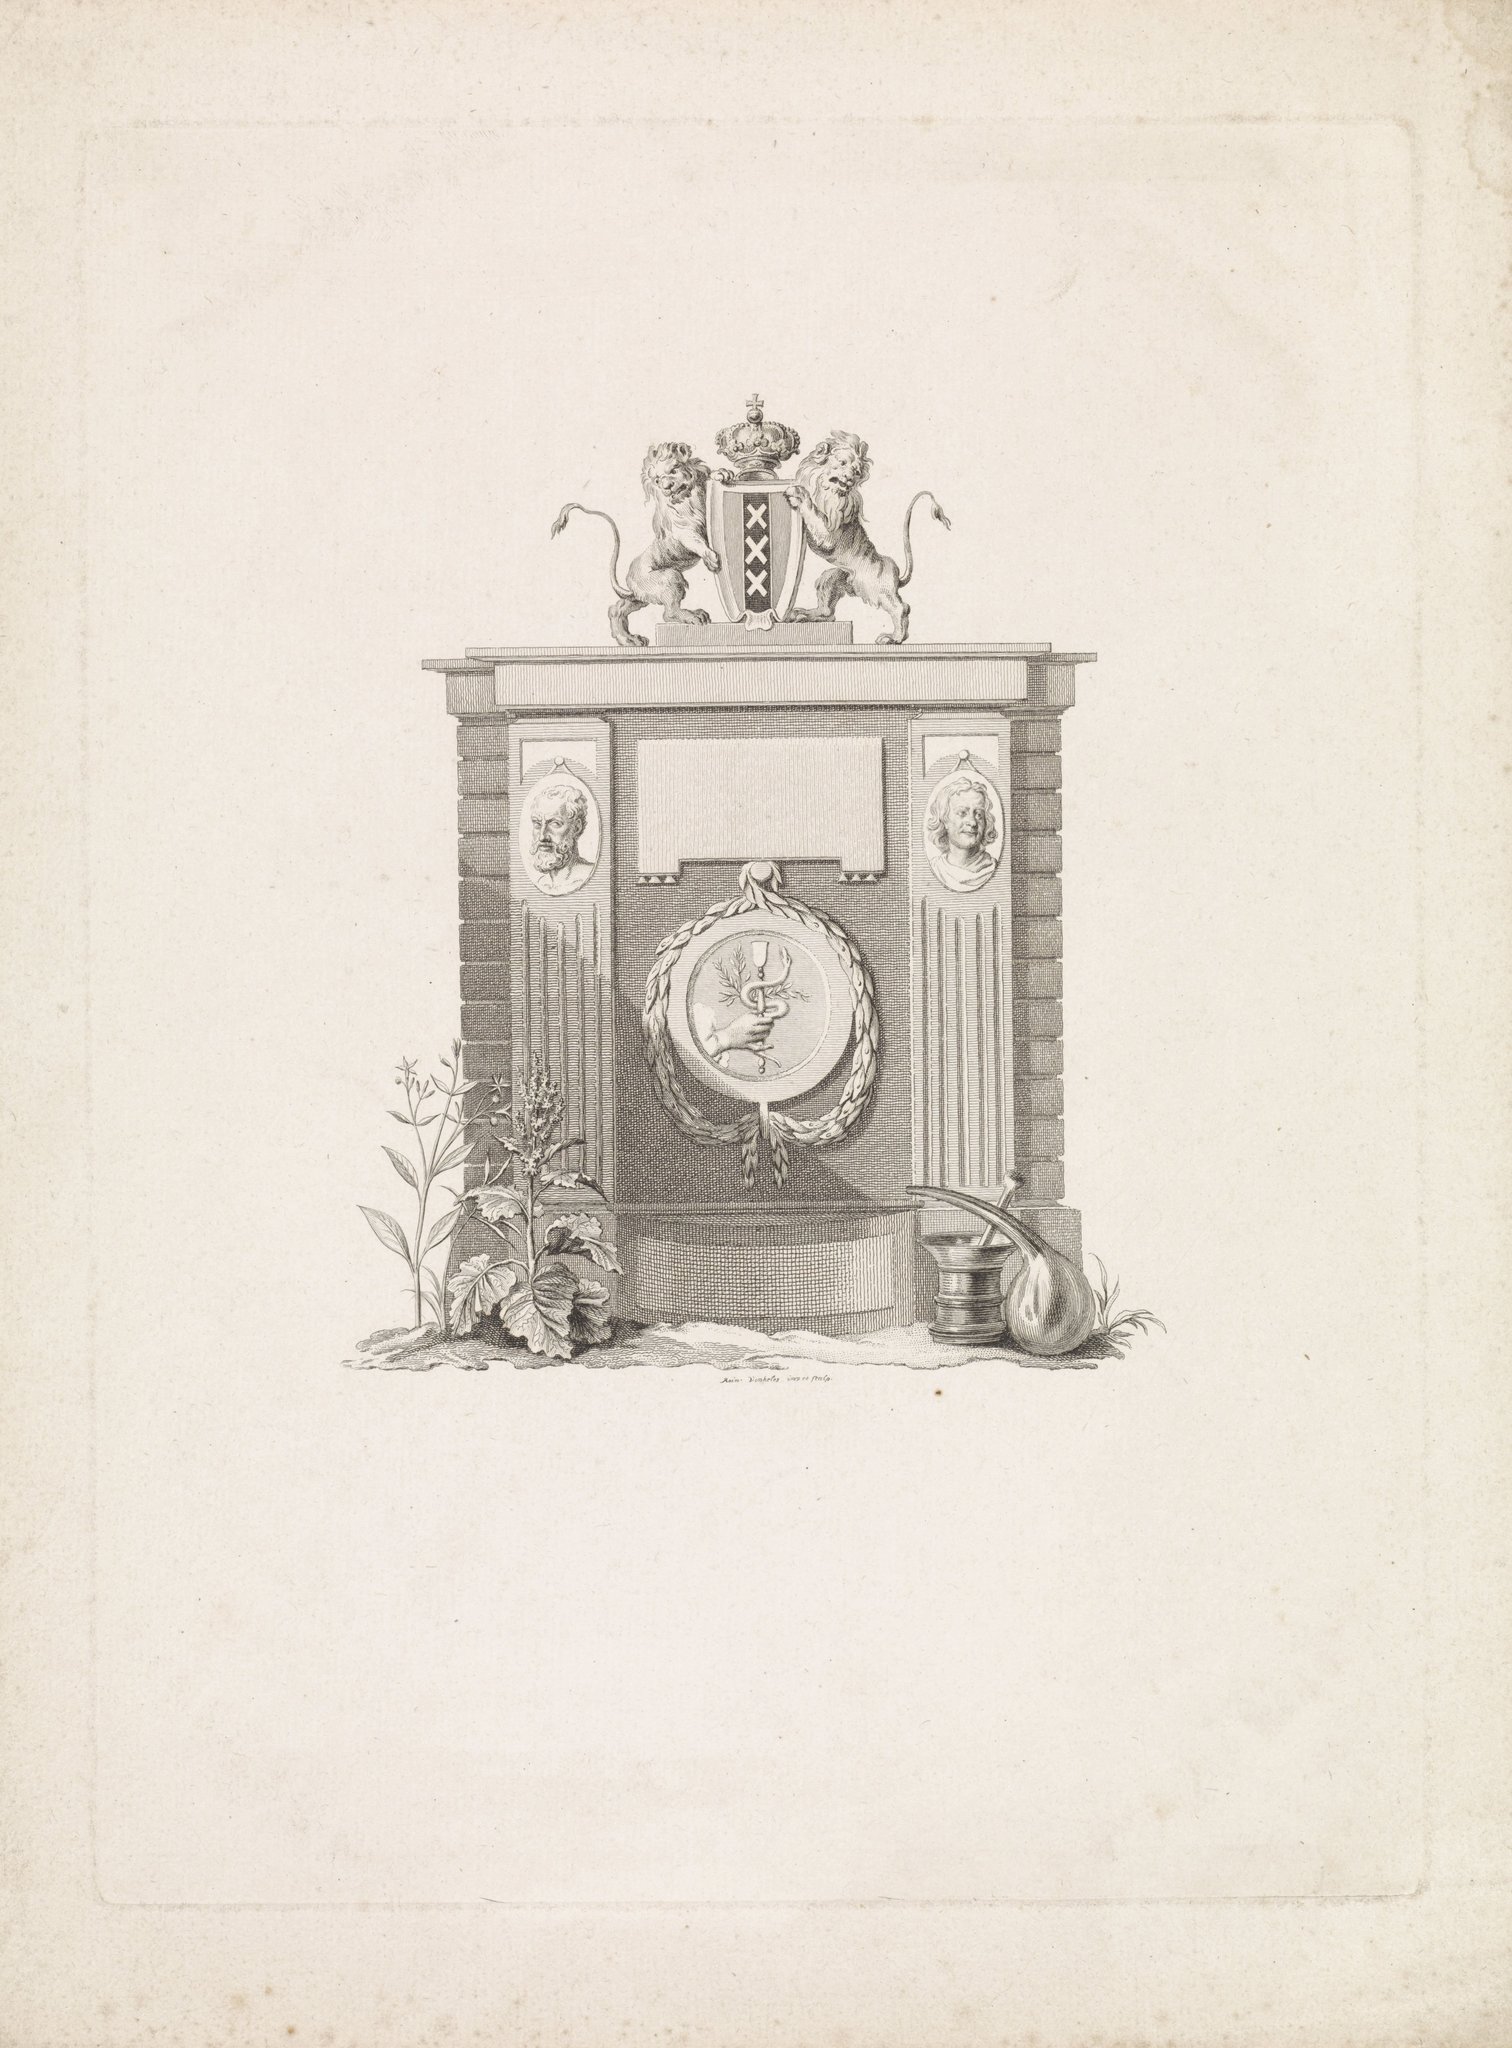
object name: print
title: Monument voor een Amsterdamse apotheker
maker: reinier vinkeles (i)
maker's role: draughtsman, print maker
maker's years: 1741-1816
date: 1751-1816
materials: paper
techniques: engraving, etching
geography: amsterdam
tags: pharmacist, druggist, apothecary; pharmacy, drugstore, dispensing chemist, tools and implements of pharmacist, armorial bearing, heraldry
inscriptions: collector's mark: Lugt 2228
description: Monument voor een onbekende Amsterdamse apotheker in de vorm van een steen waarop twee portretten, een van Theophrastus van Eresus. In het midden van de steen een apothekerssymbool, met kelk en een slang. Voor de steen een vijzel, alambiek en een tabaksplant. Bovenop het monument prijkt het stadswapen van Amsterdam.